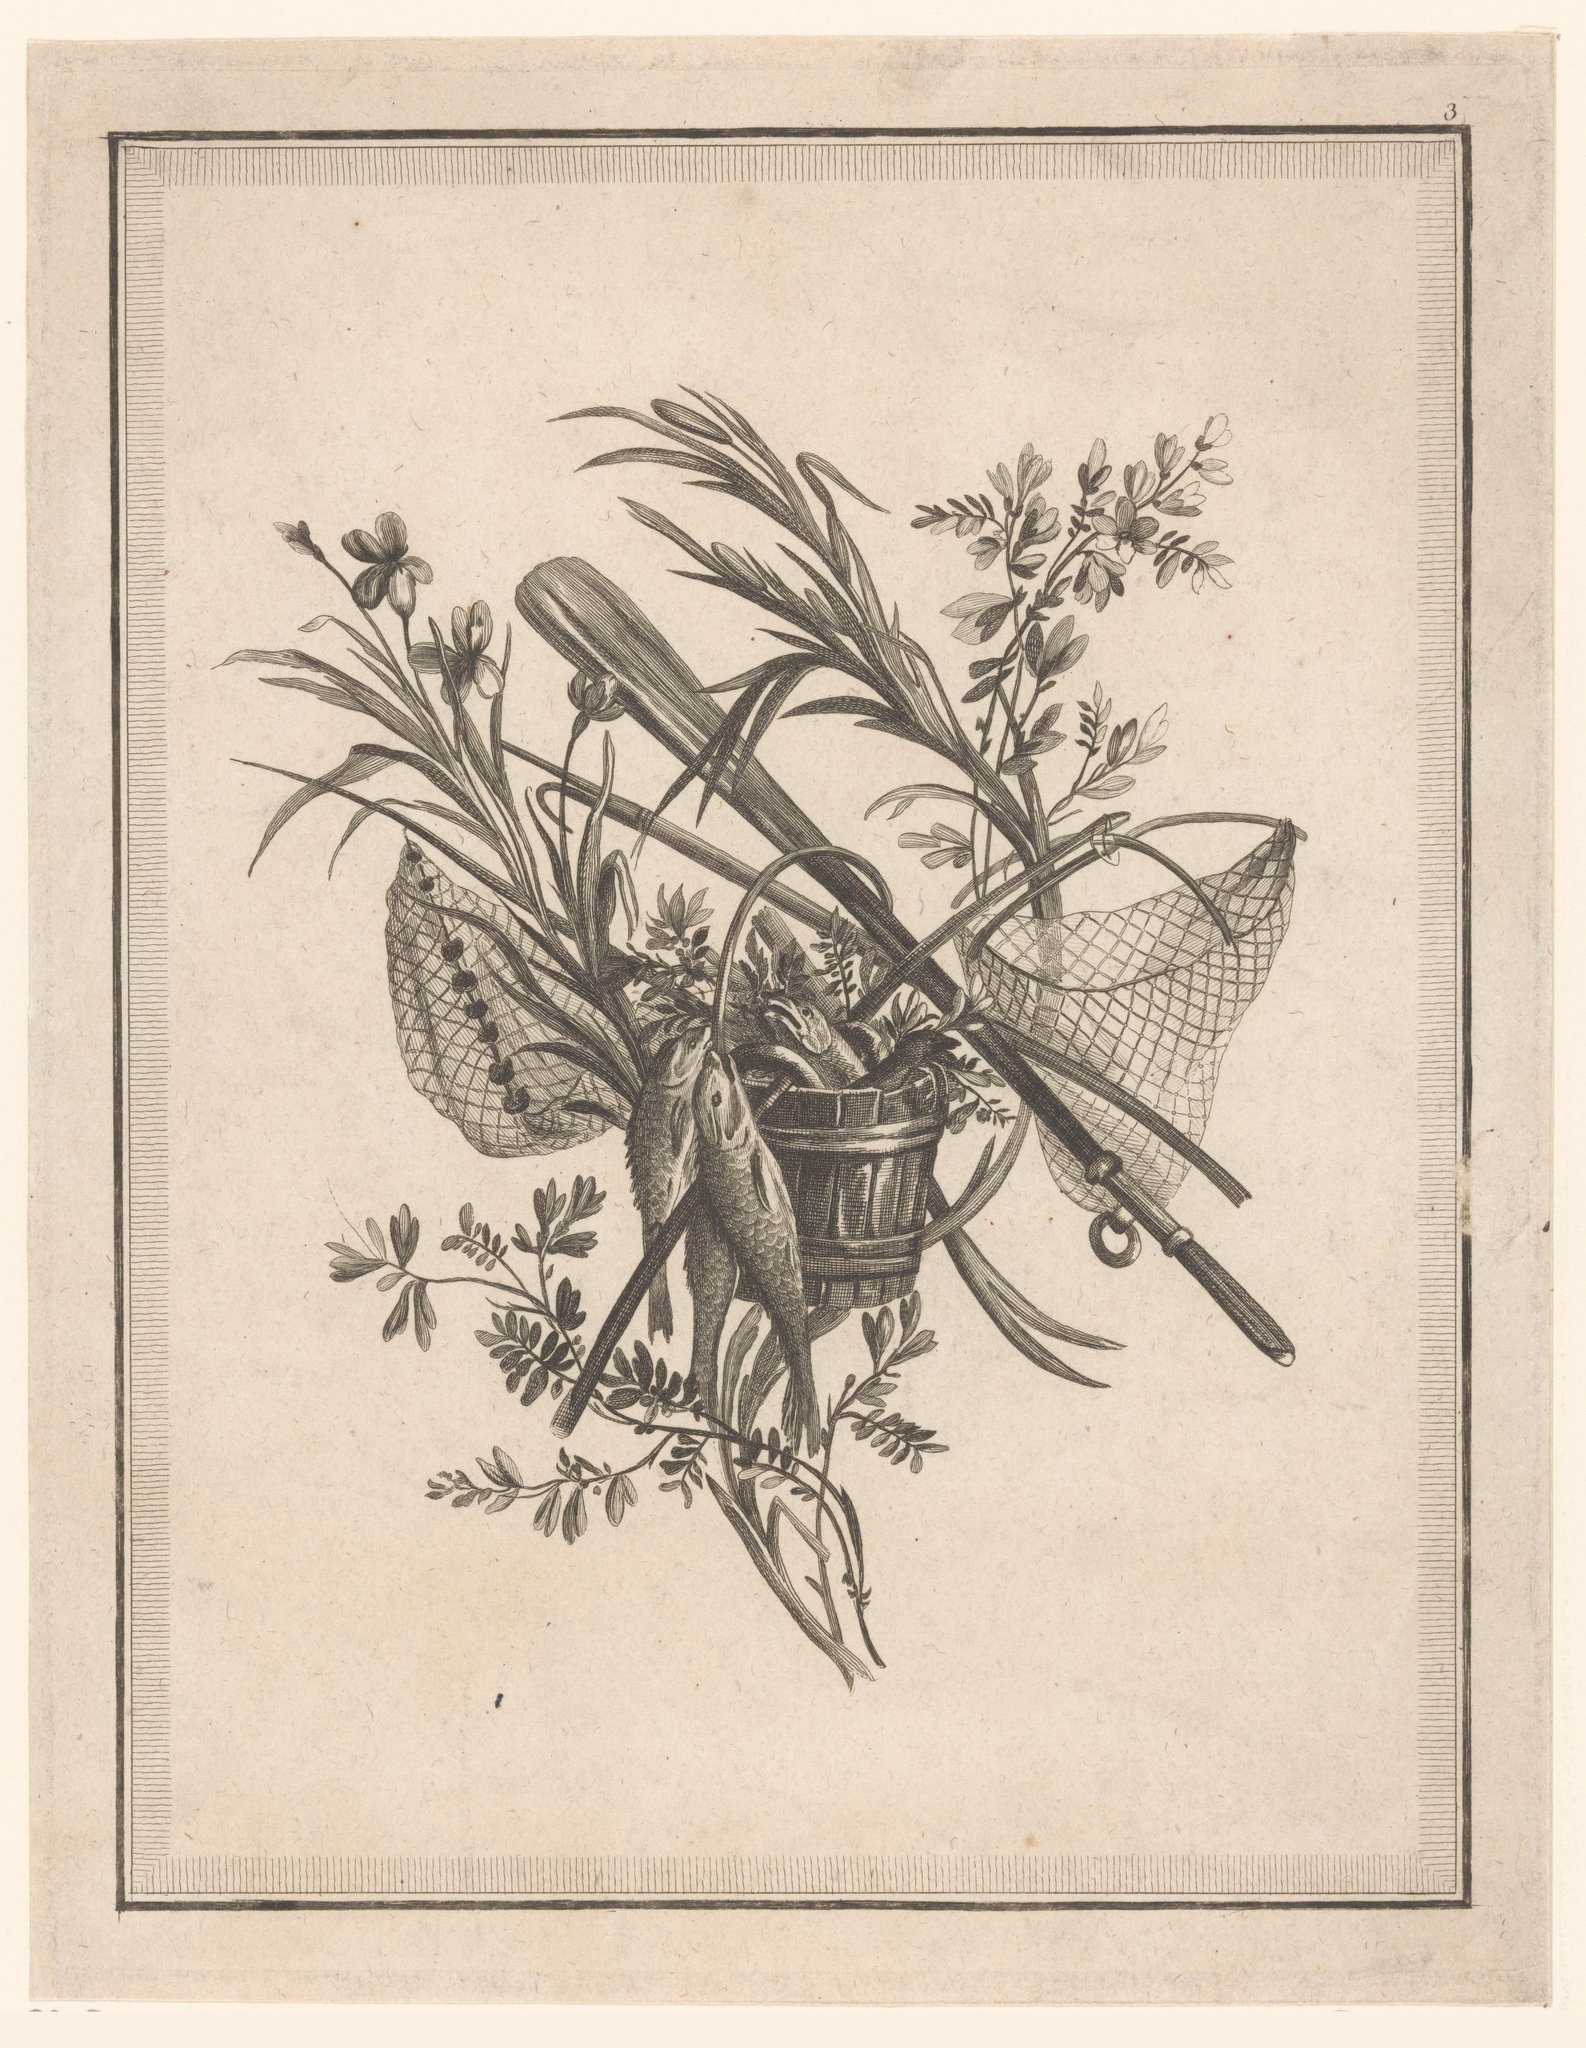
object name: ornament print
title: Trofee met vissersattributen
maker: etienne claude voysard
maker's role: print maker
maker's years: 1746-1812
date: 1778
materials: paper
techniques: etching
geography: paris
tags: trophy, i.e.: decorative arrangement of symbolic or typical objects ~ ornament, fishing (sports)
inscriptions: collector's mark: Lugt 2228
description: Een trofee met vissersattributen zoals netten en een emmer met vissen.